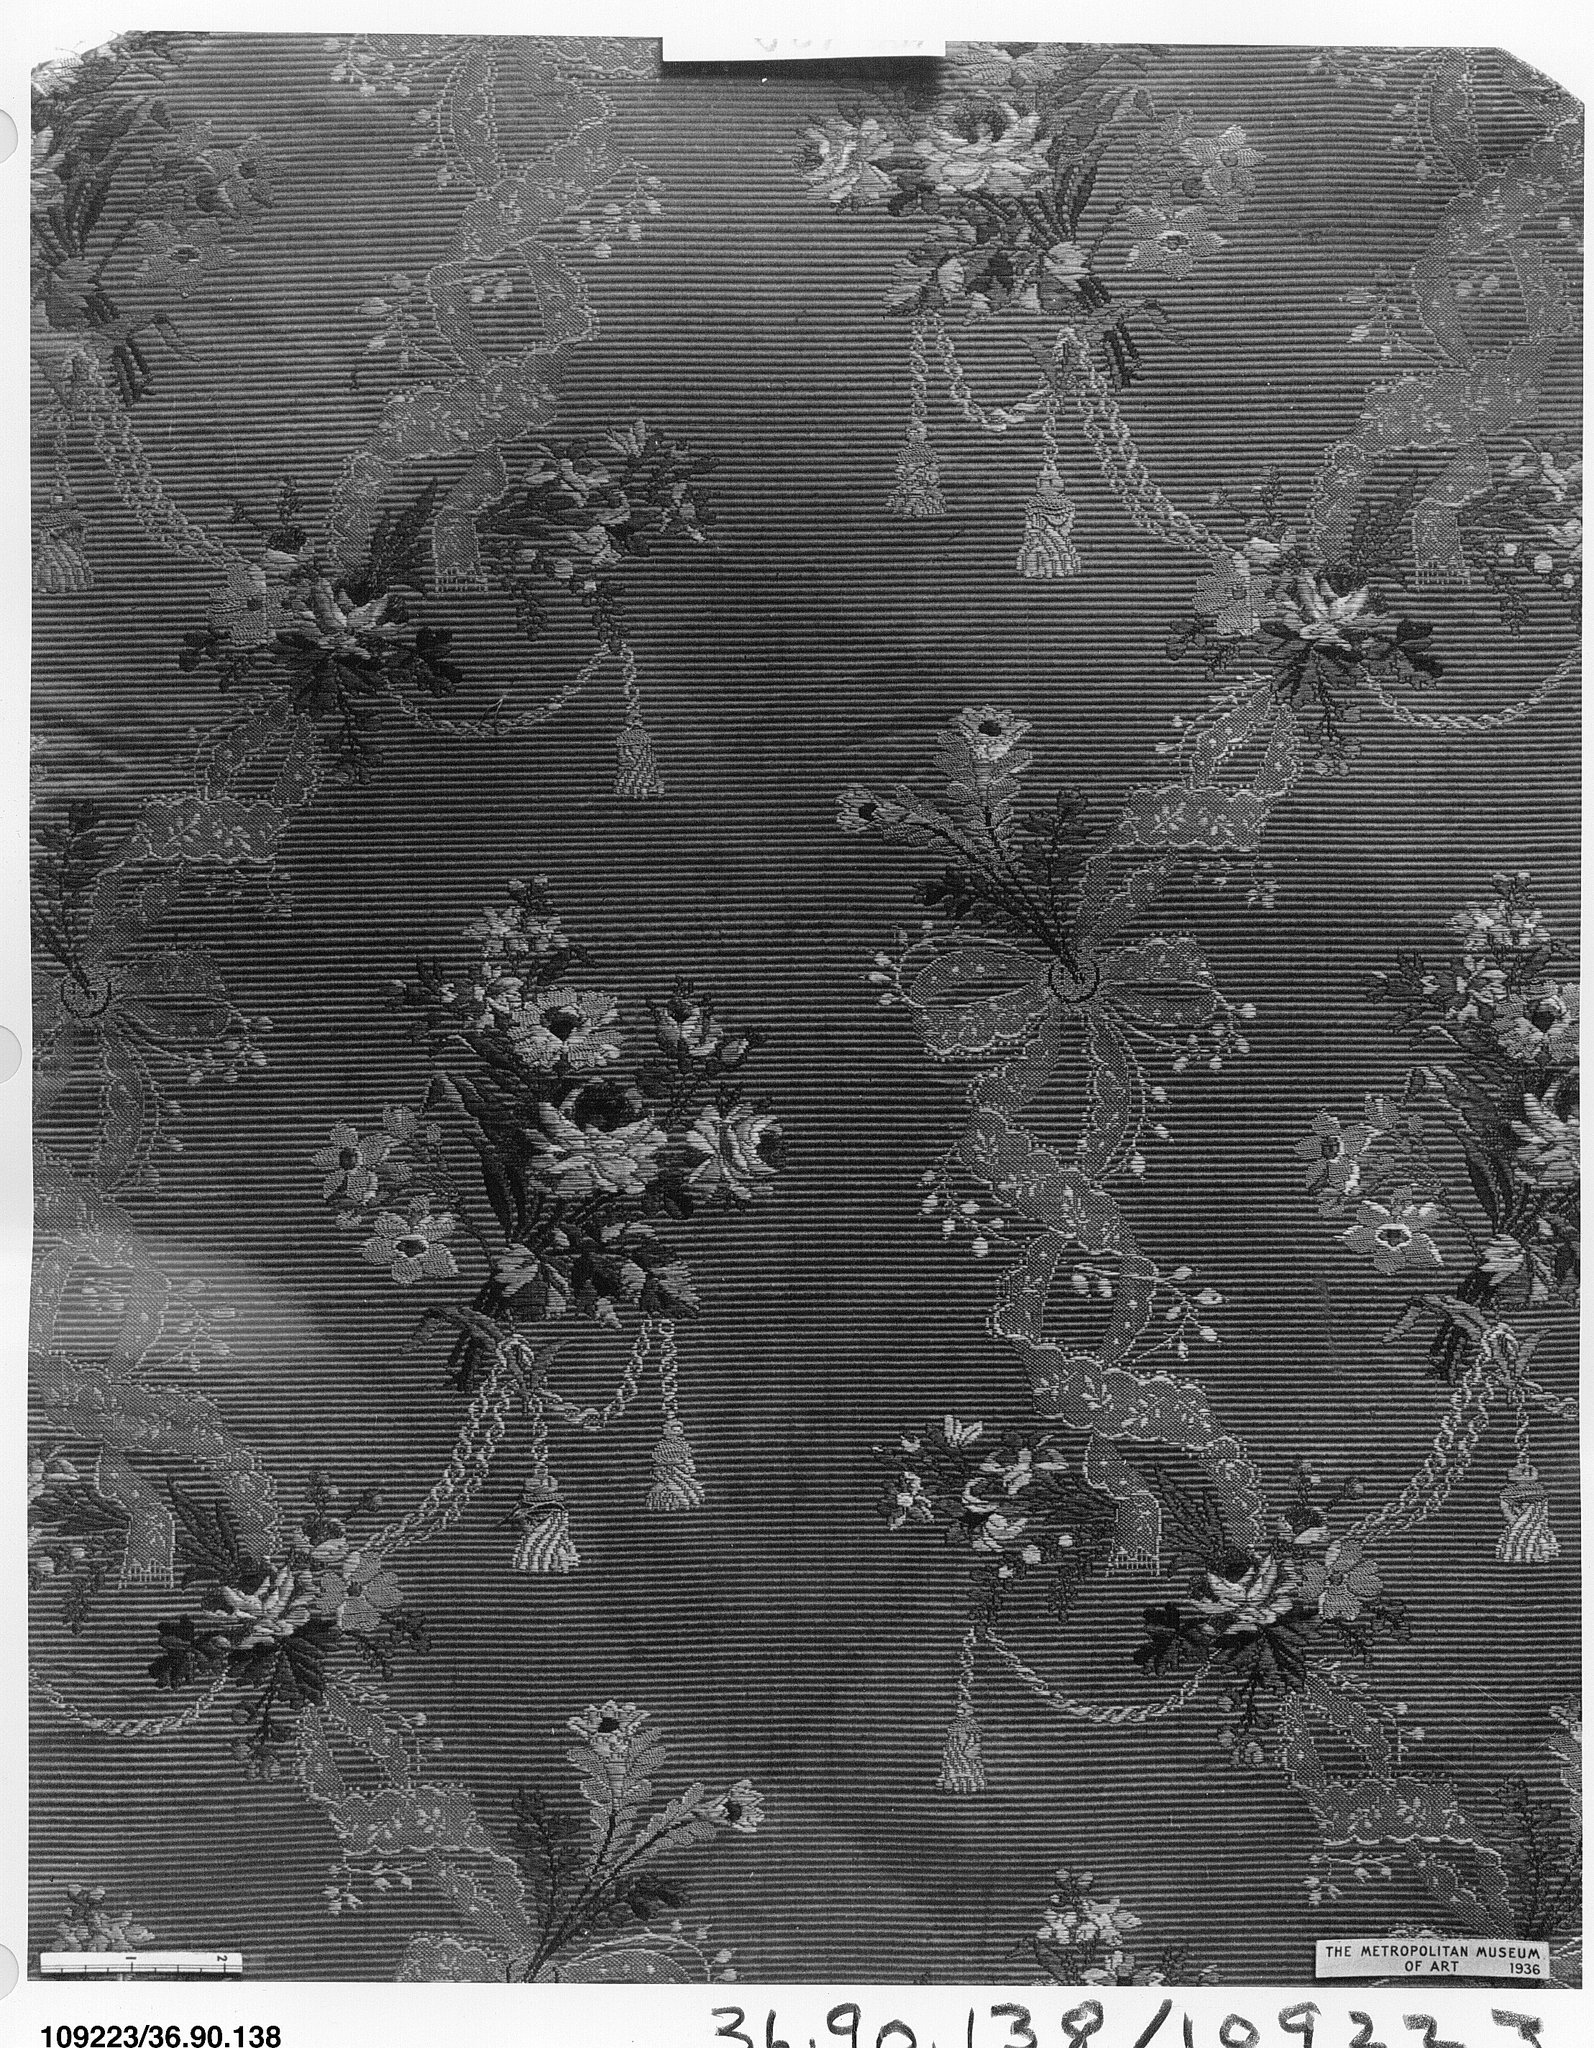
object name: piece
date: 1760-1770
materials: silk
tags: flowers